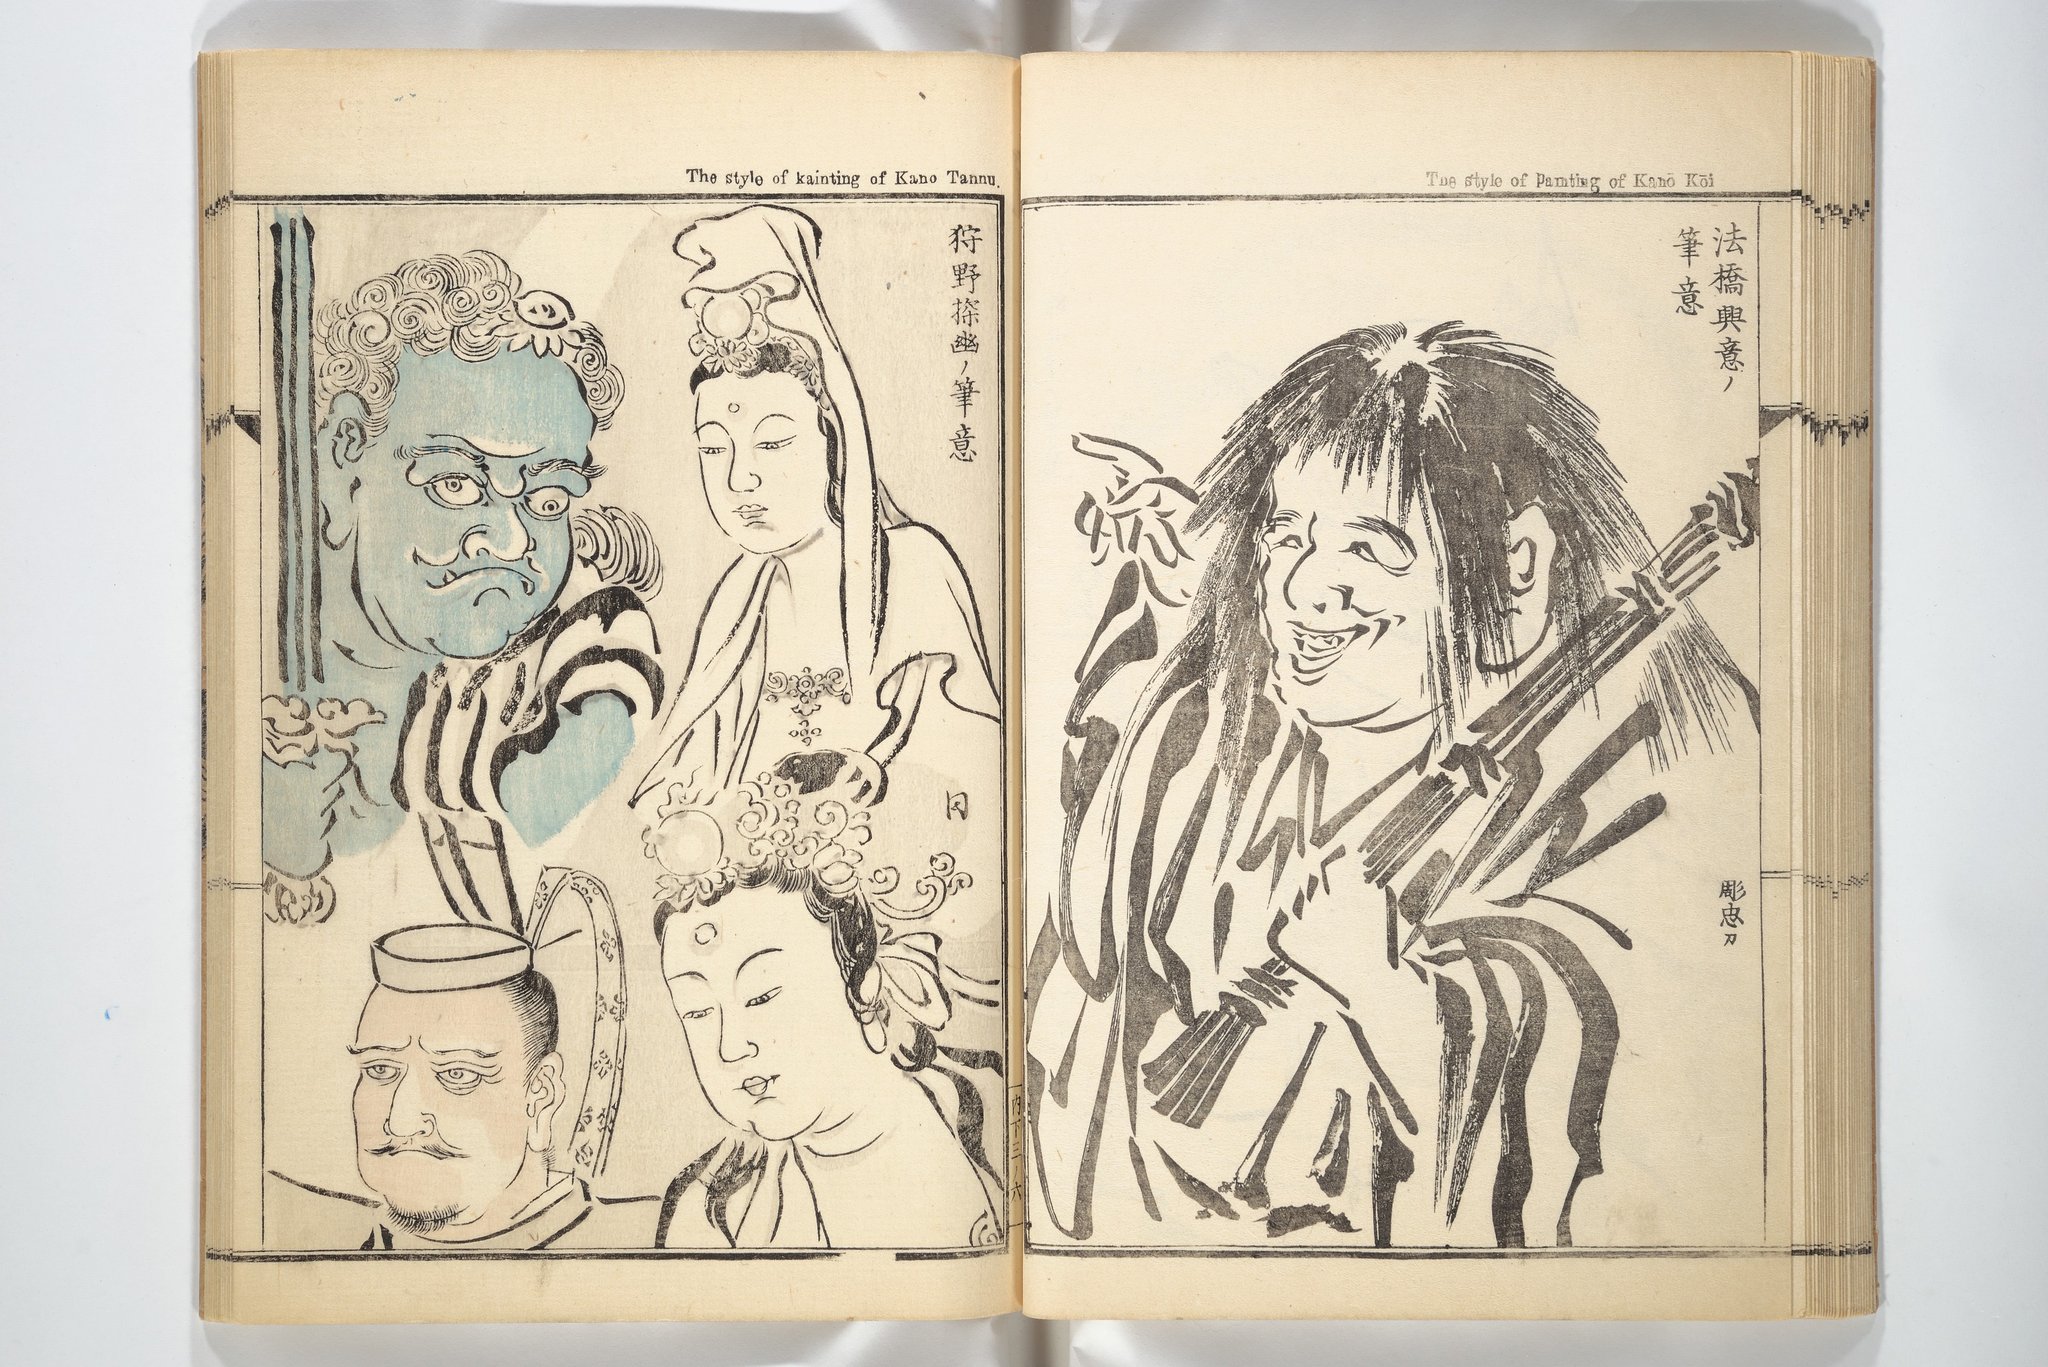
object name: illustrated book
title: Kyōsai’s Treatise on Painting (Kyōsai gadan) 暁斎画談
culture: japanese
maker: kawanabe kyōsai 河鍋暁斎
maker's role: artist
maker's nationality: japanese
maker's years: 1831-1889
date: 1887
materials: ink, paper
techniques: woodblock print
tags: men